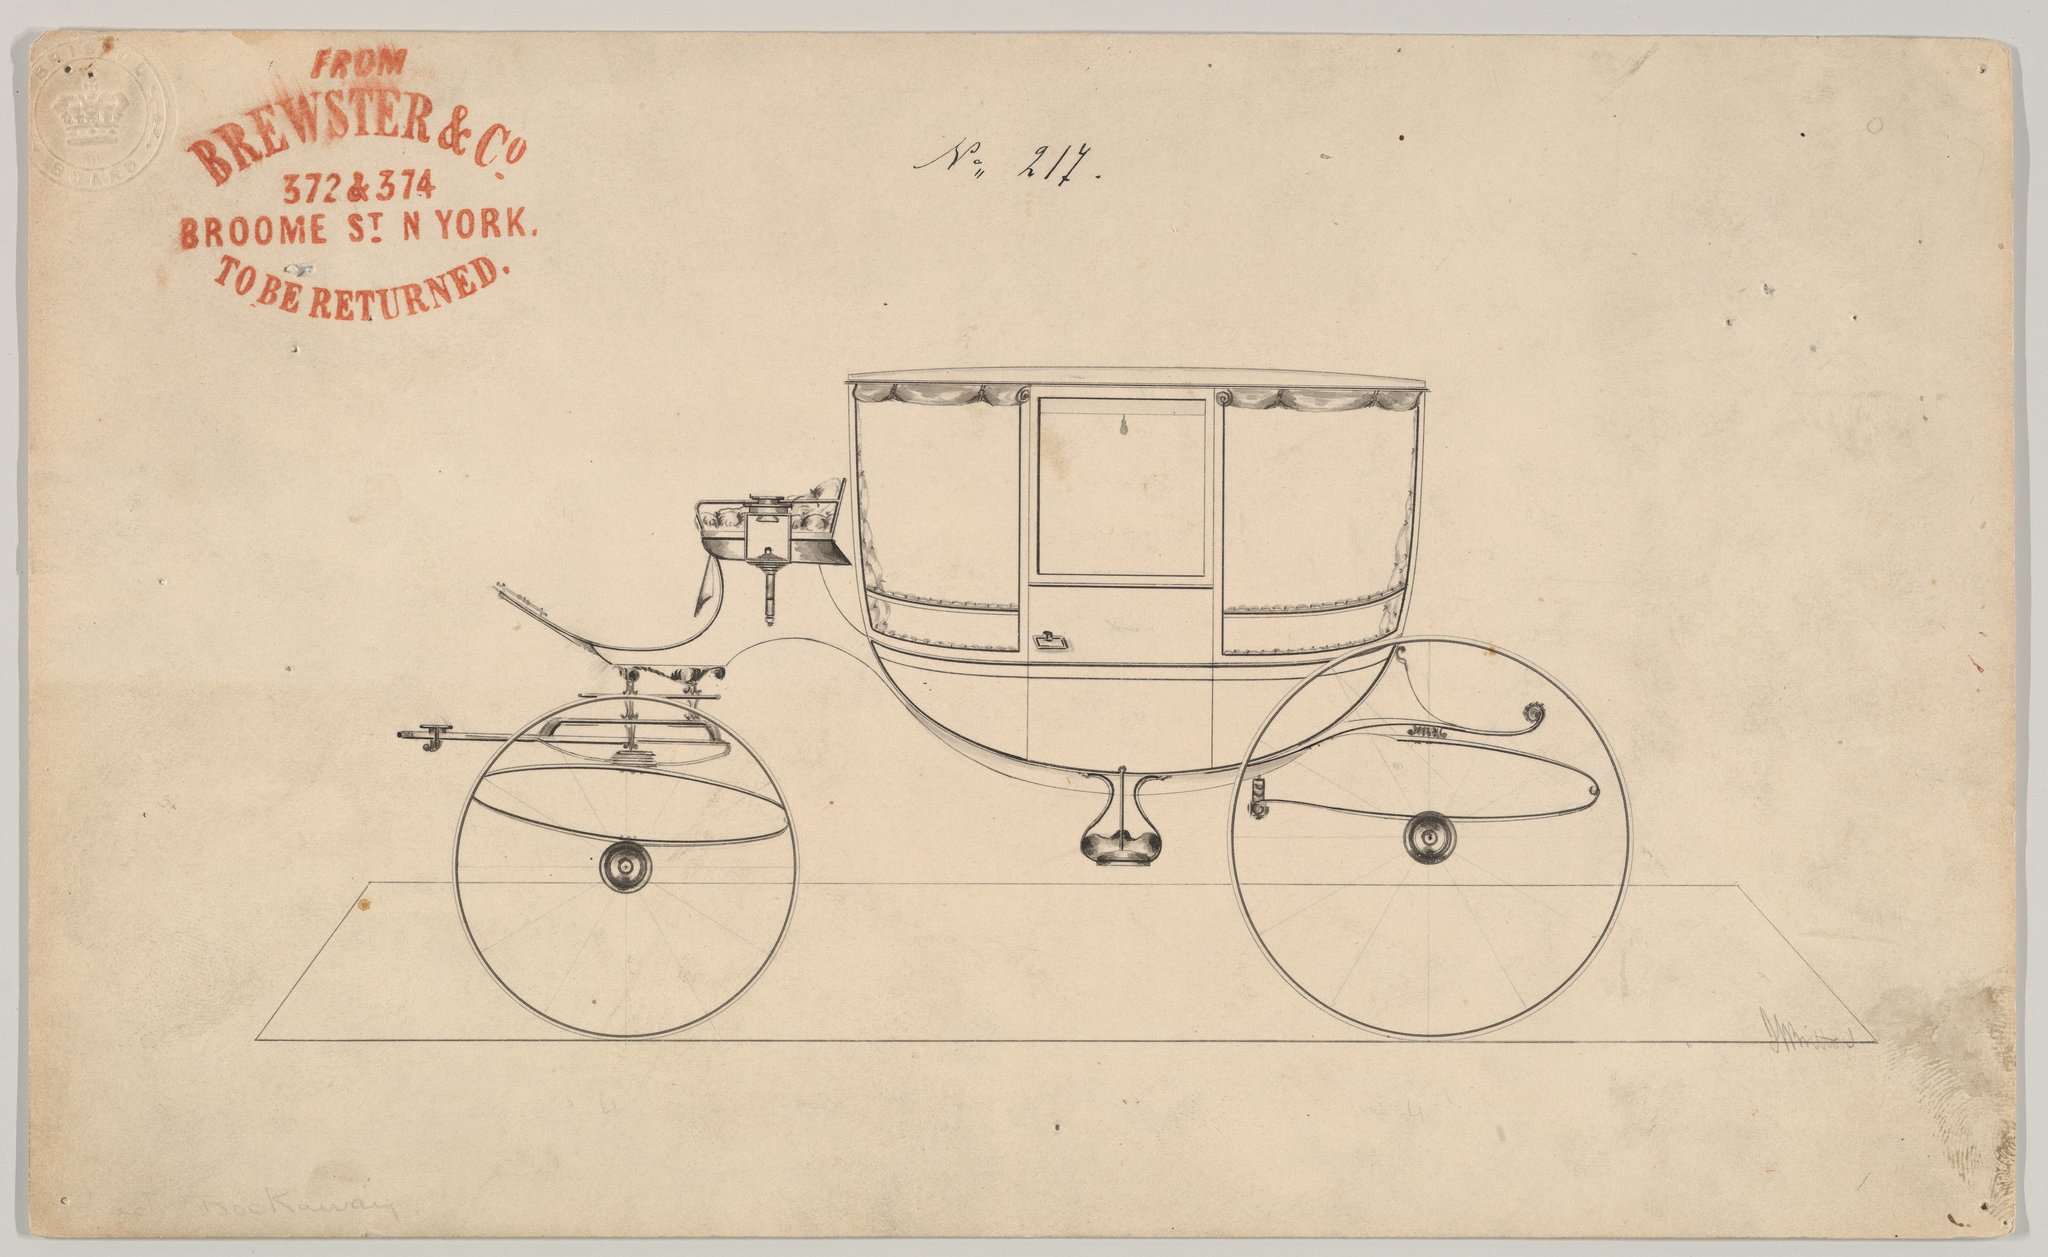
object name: drawing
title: Coach #217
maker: brewster & co.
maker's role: manufacturer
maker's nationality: american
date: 1860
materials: graphite, ink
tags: carriages